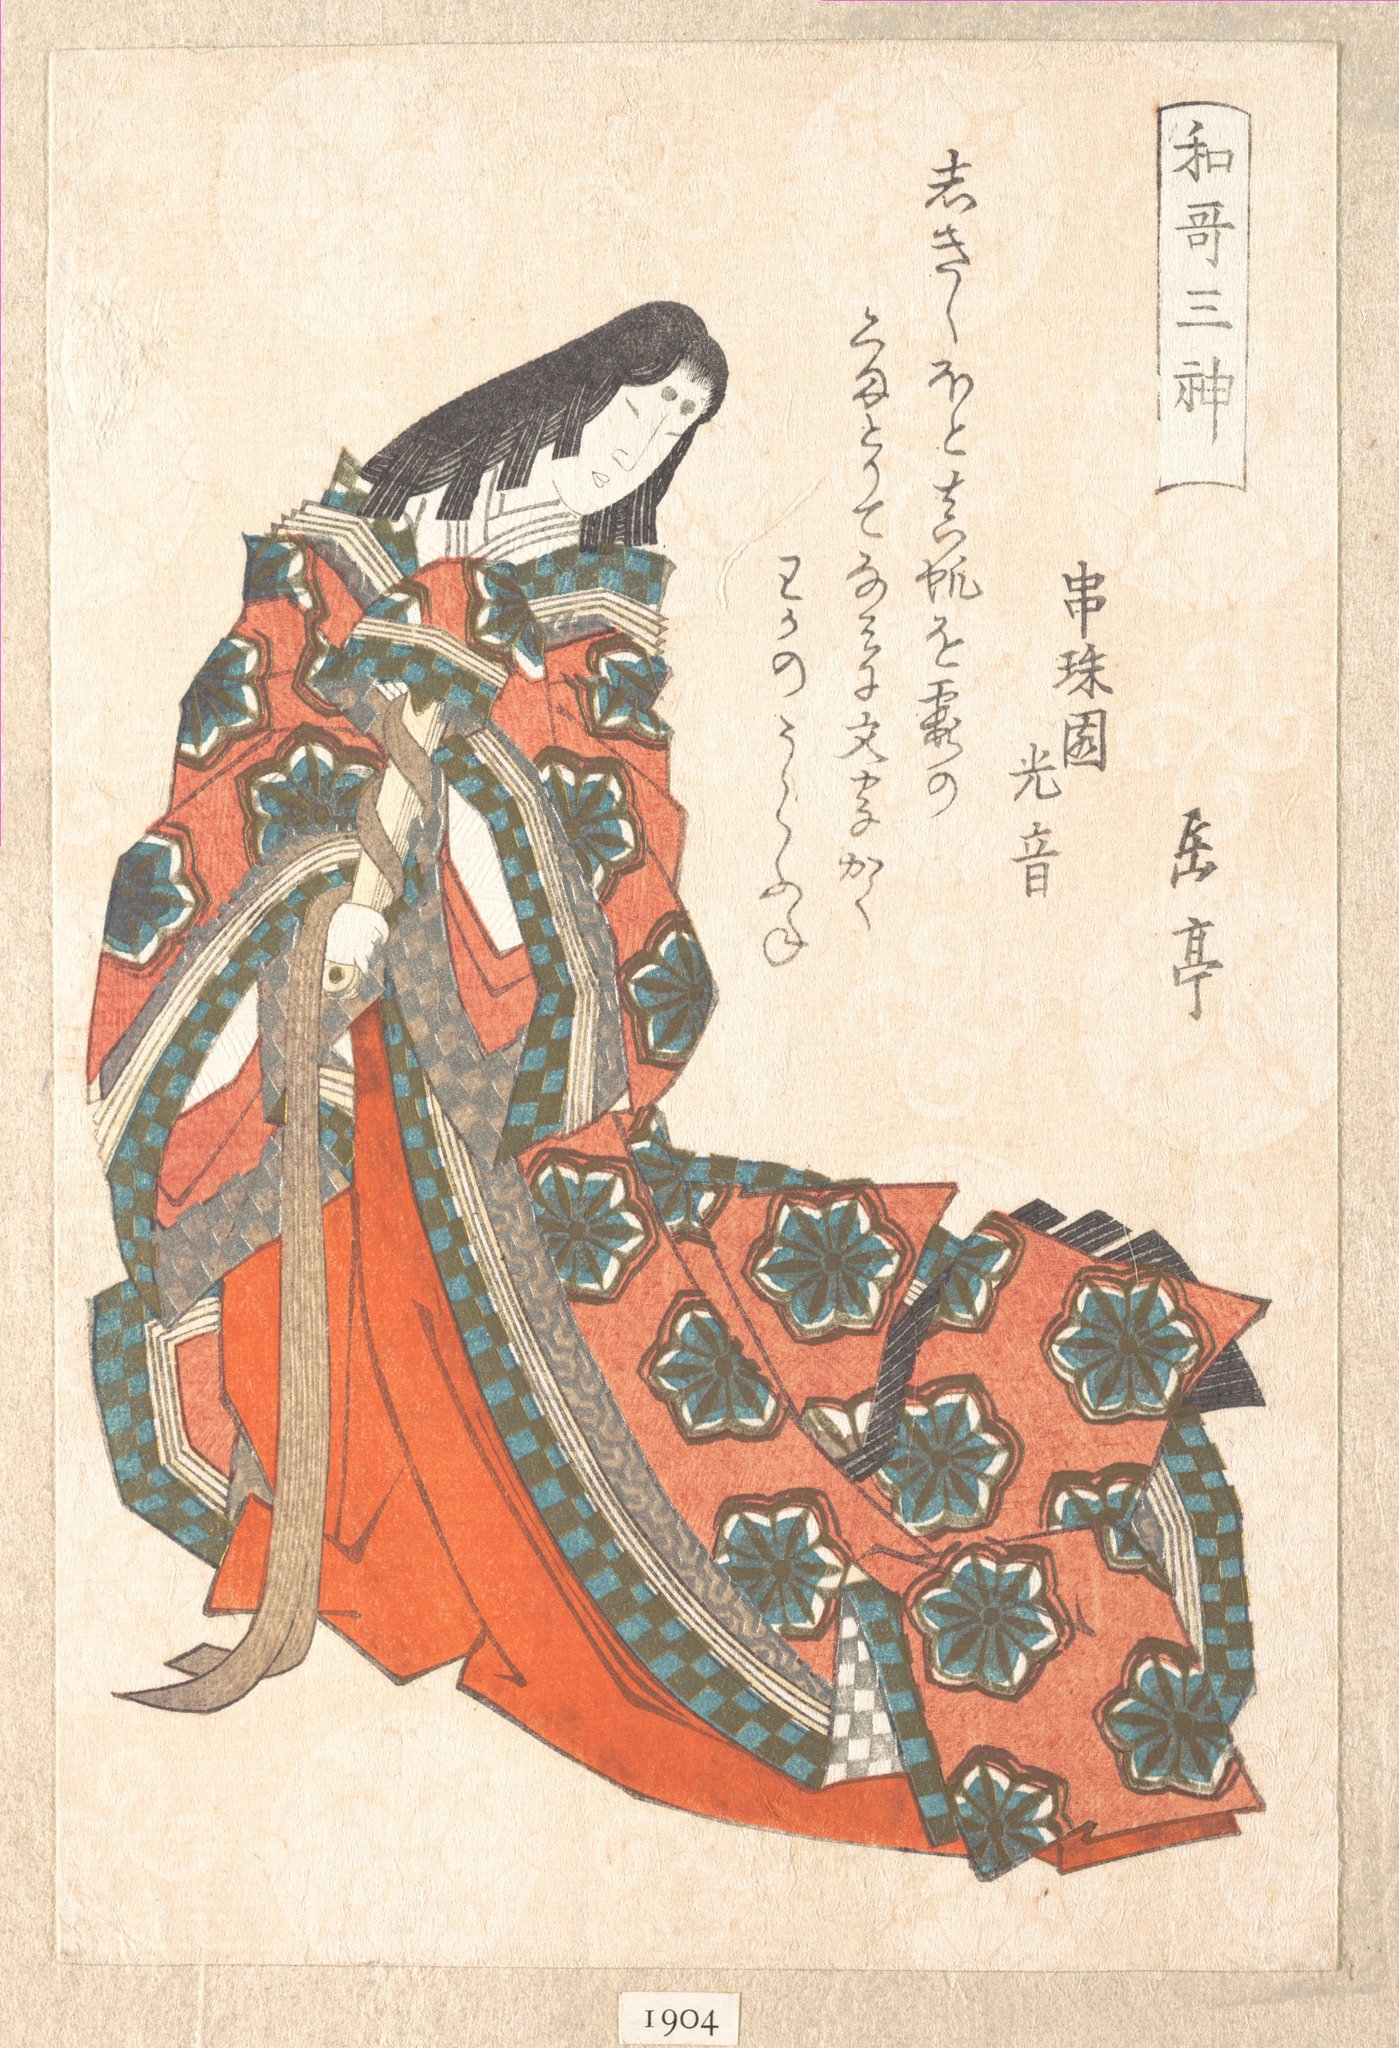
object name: print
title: Sotoori-hime (early 5th century), One of the Three Gods of Poetry From the Spring Rain Collection (Harusame shū), vol. 1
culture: japanese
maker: yashima gakutei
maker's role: artist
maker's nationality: japanese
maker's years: 1786-1868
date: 1820-1829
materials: ink, paper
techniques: surimono, woodblock print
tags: women